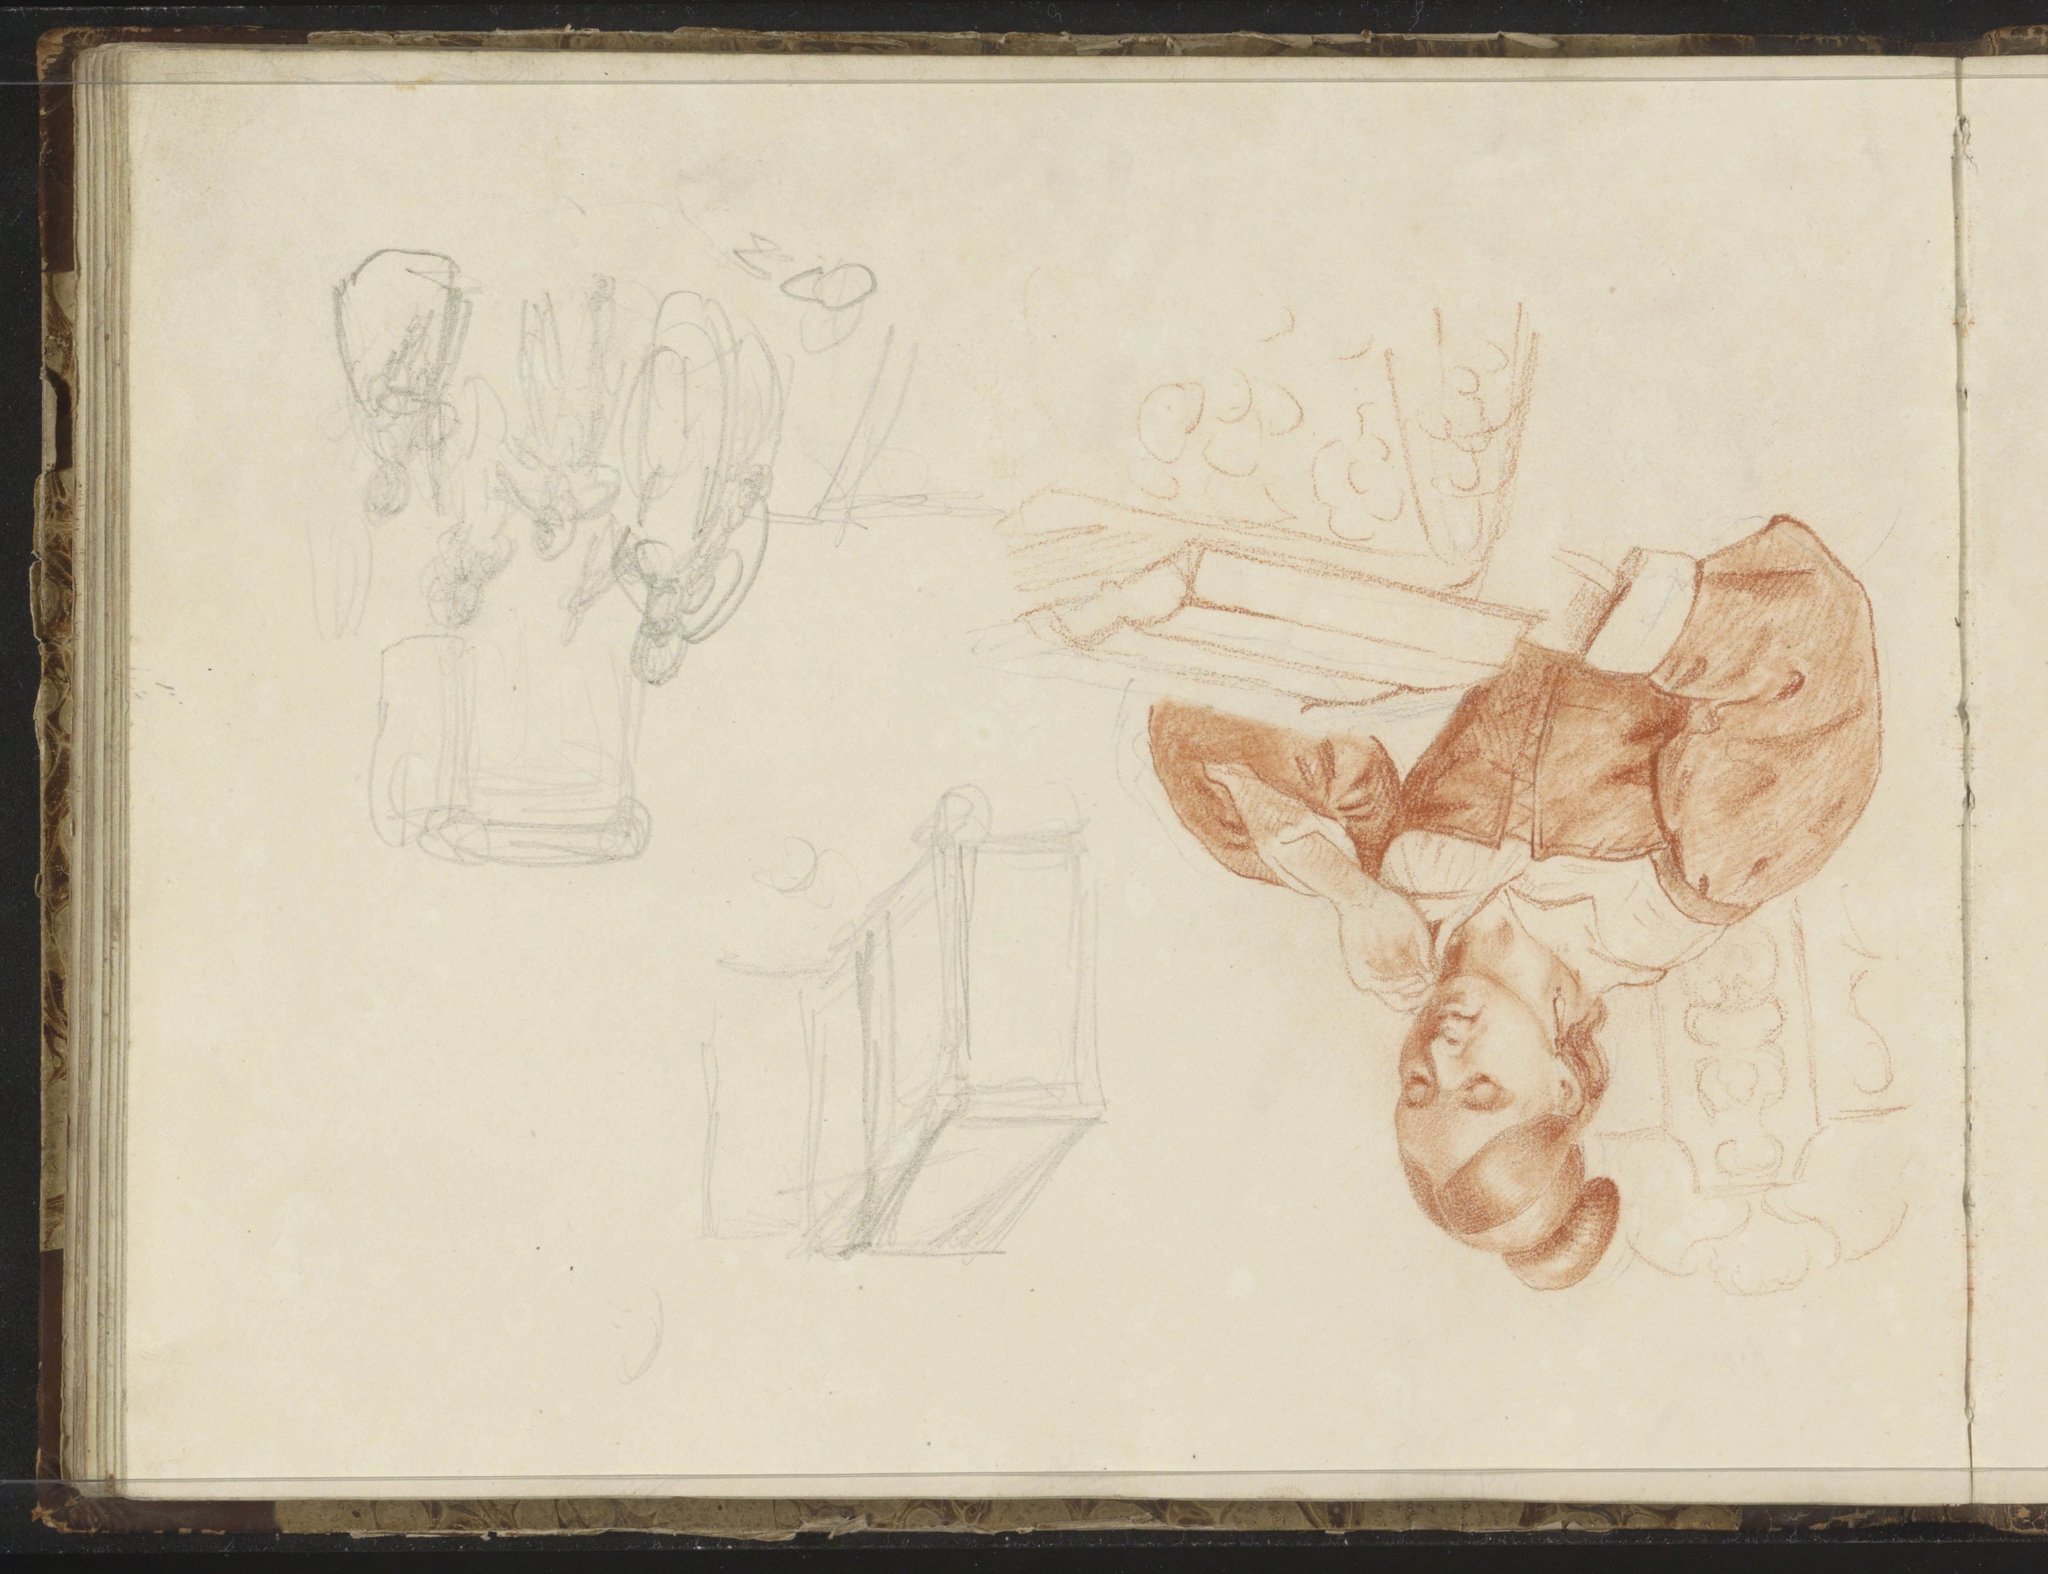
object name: sketchbook leaf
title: Studieblad, onder andere met een lezende vrouw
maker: willem hendrik schmidt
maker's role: draughtsman, painter, print maker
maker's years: 1809-1849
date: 1819-1849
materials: chalk, paper, pencil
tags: reading, furniture for storage, anatomy (non-medical), book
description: Tevens studies van kasten en figuren. Blad 48 verso uit een schetsboek met 52 bladen.